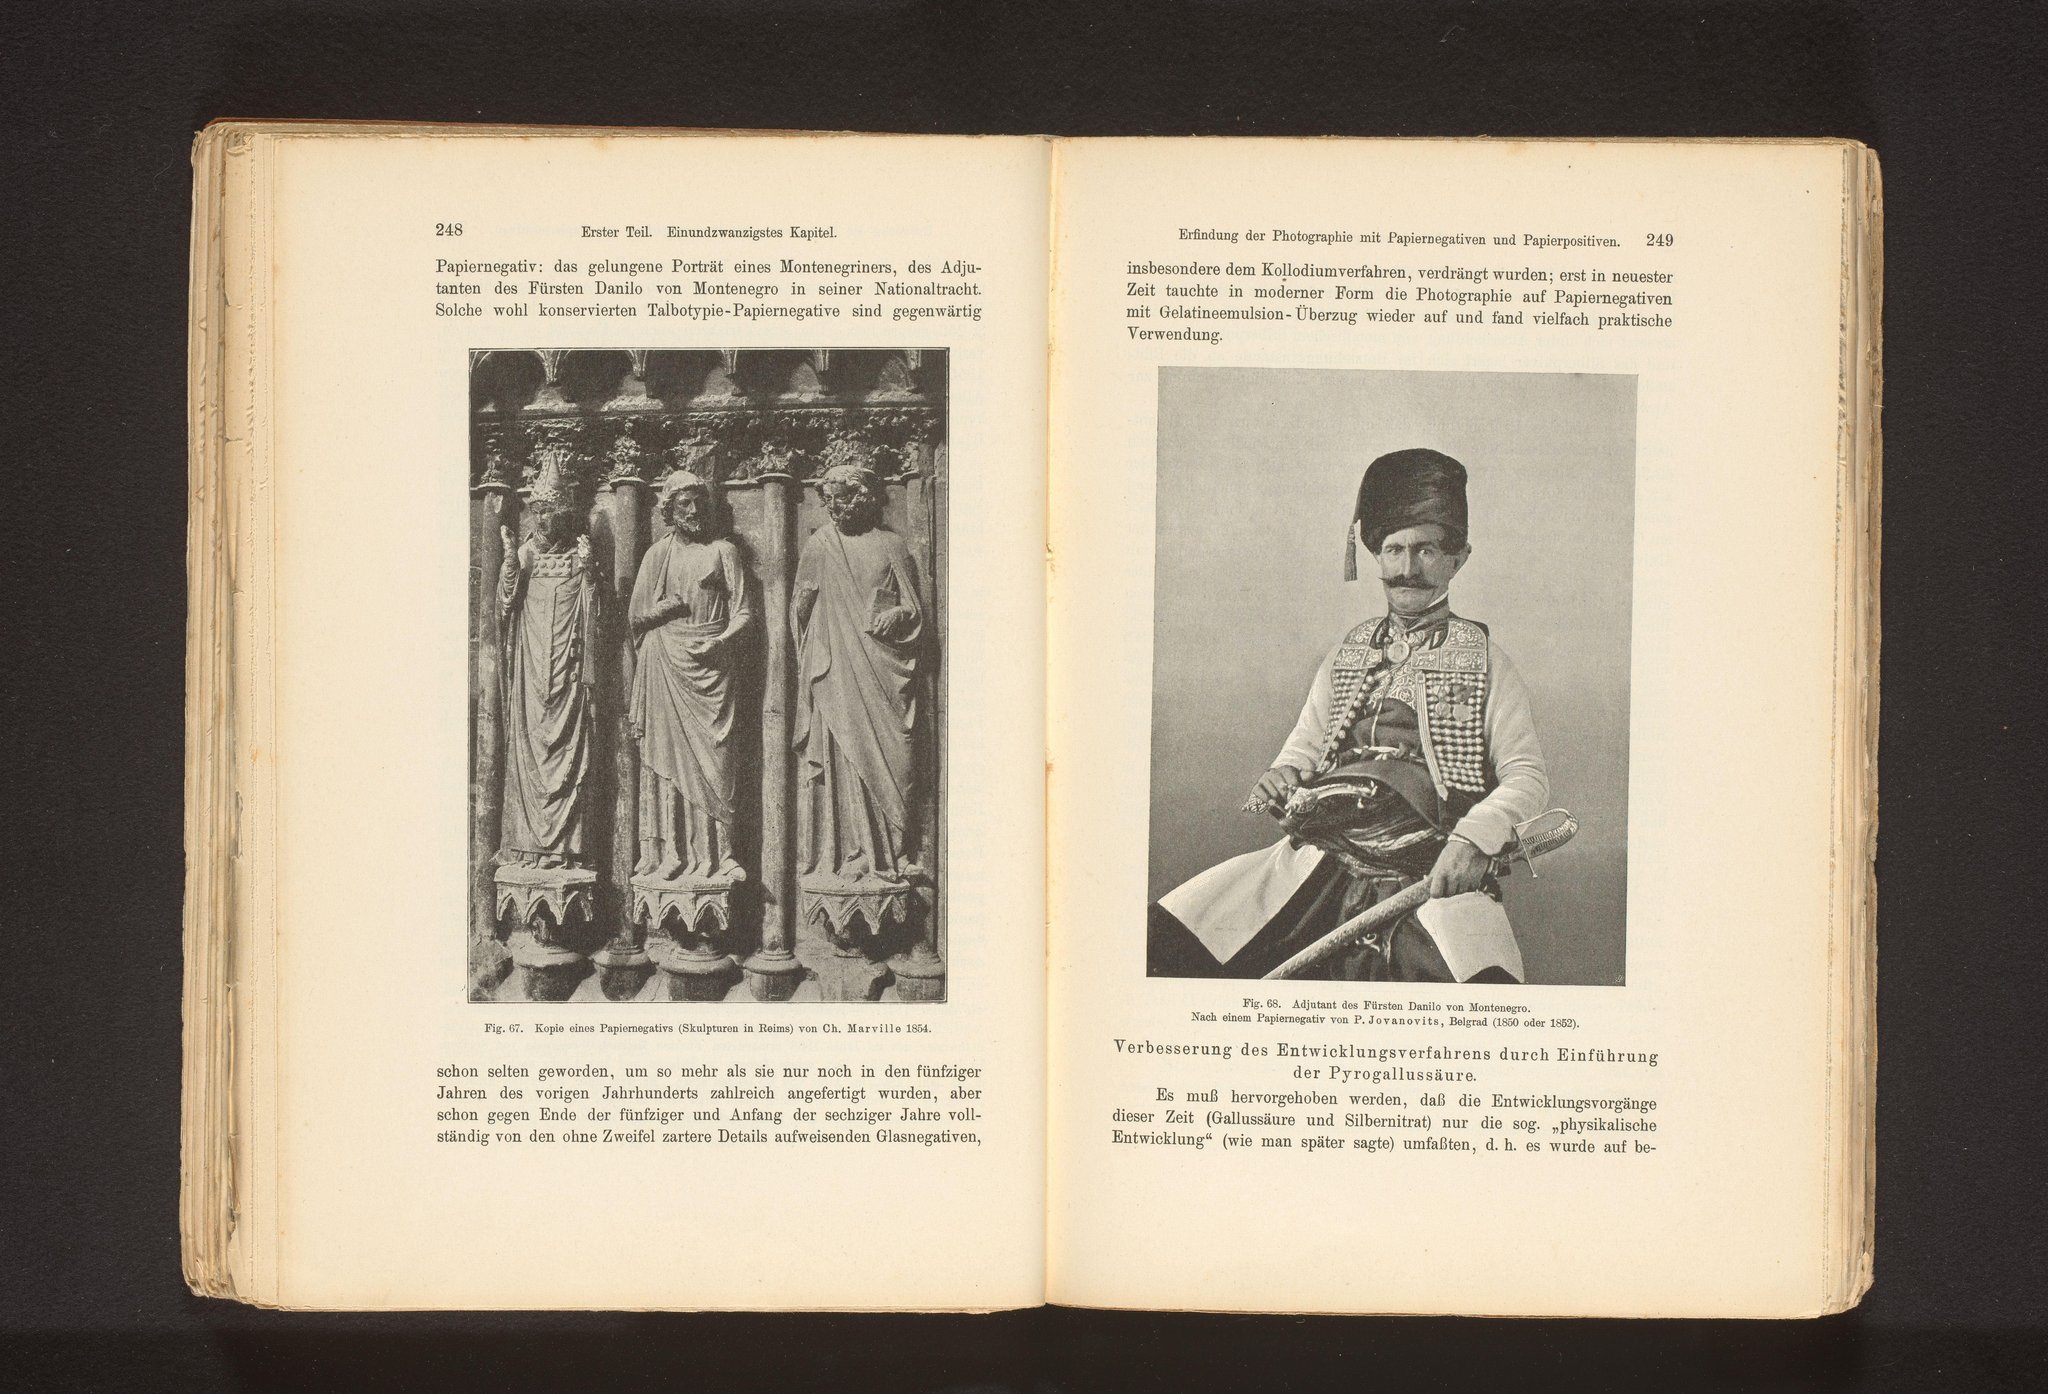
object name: photomechanical print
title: Adjutant des Fürsten Danilo von Montenegro. Nach einem Papiernegativ von P. Jovanovits, Belgrad (1850 oder 1852)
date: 1900-1905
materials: paper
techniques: autotype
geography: belgrade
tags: commander-in-chief, general, marshal, military clothing and other equipment (uniforms, cap, armour, helmet, etc.)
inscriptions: number: ‘Fig. 68.’